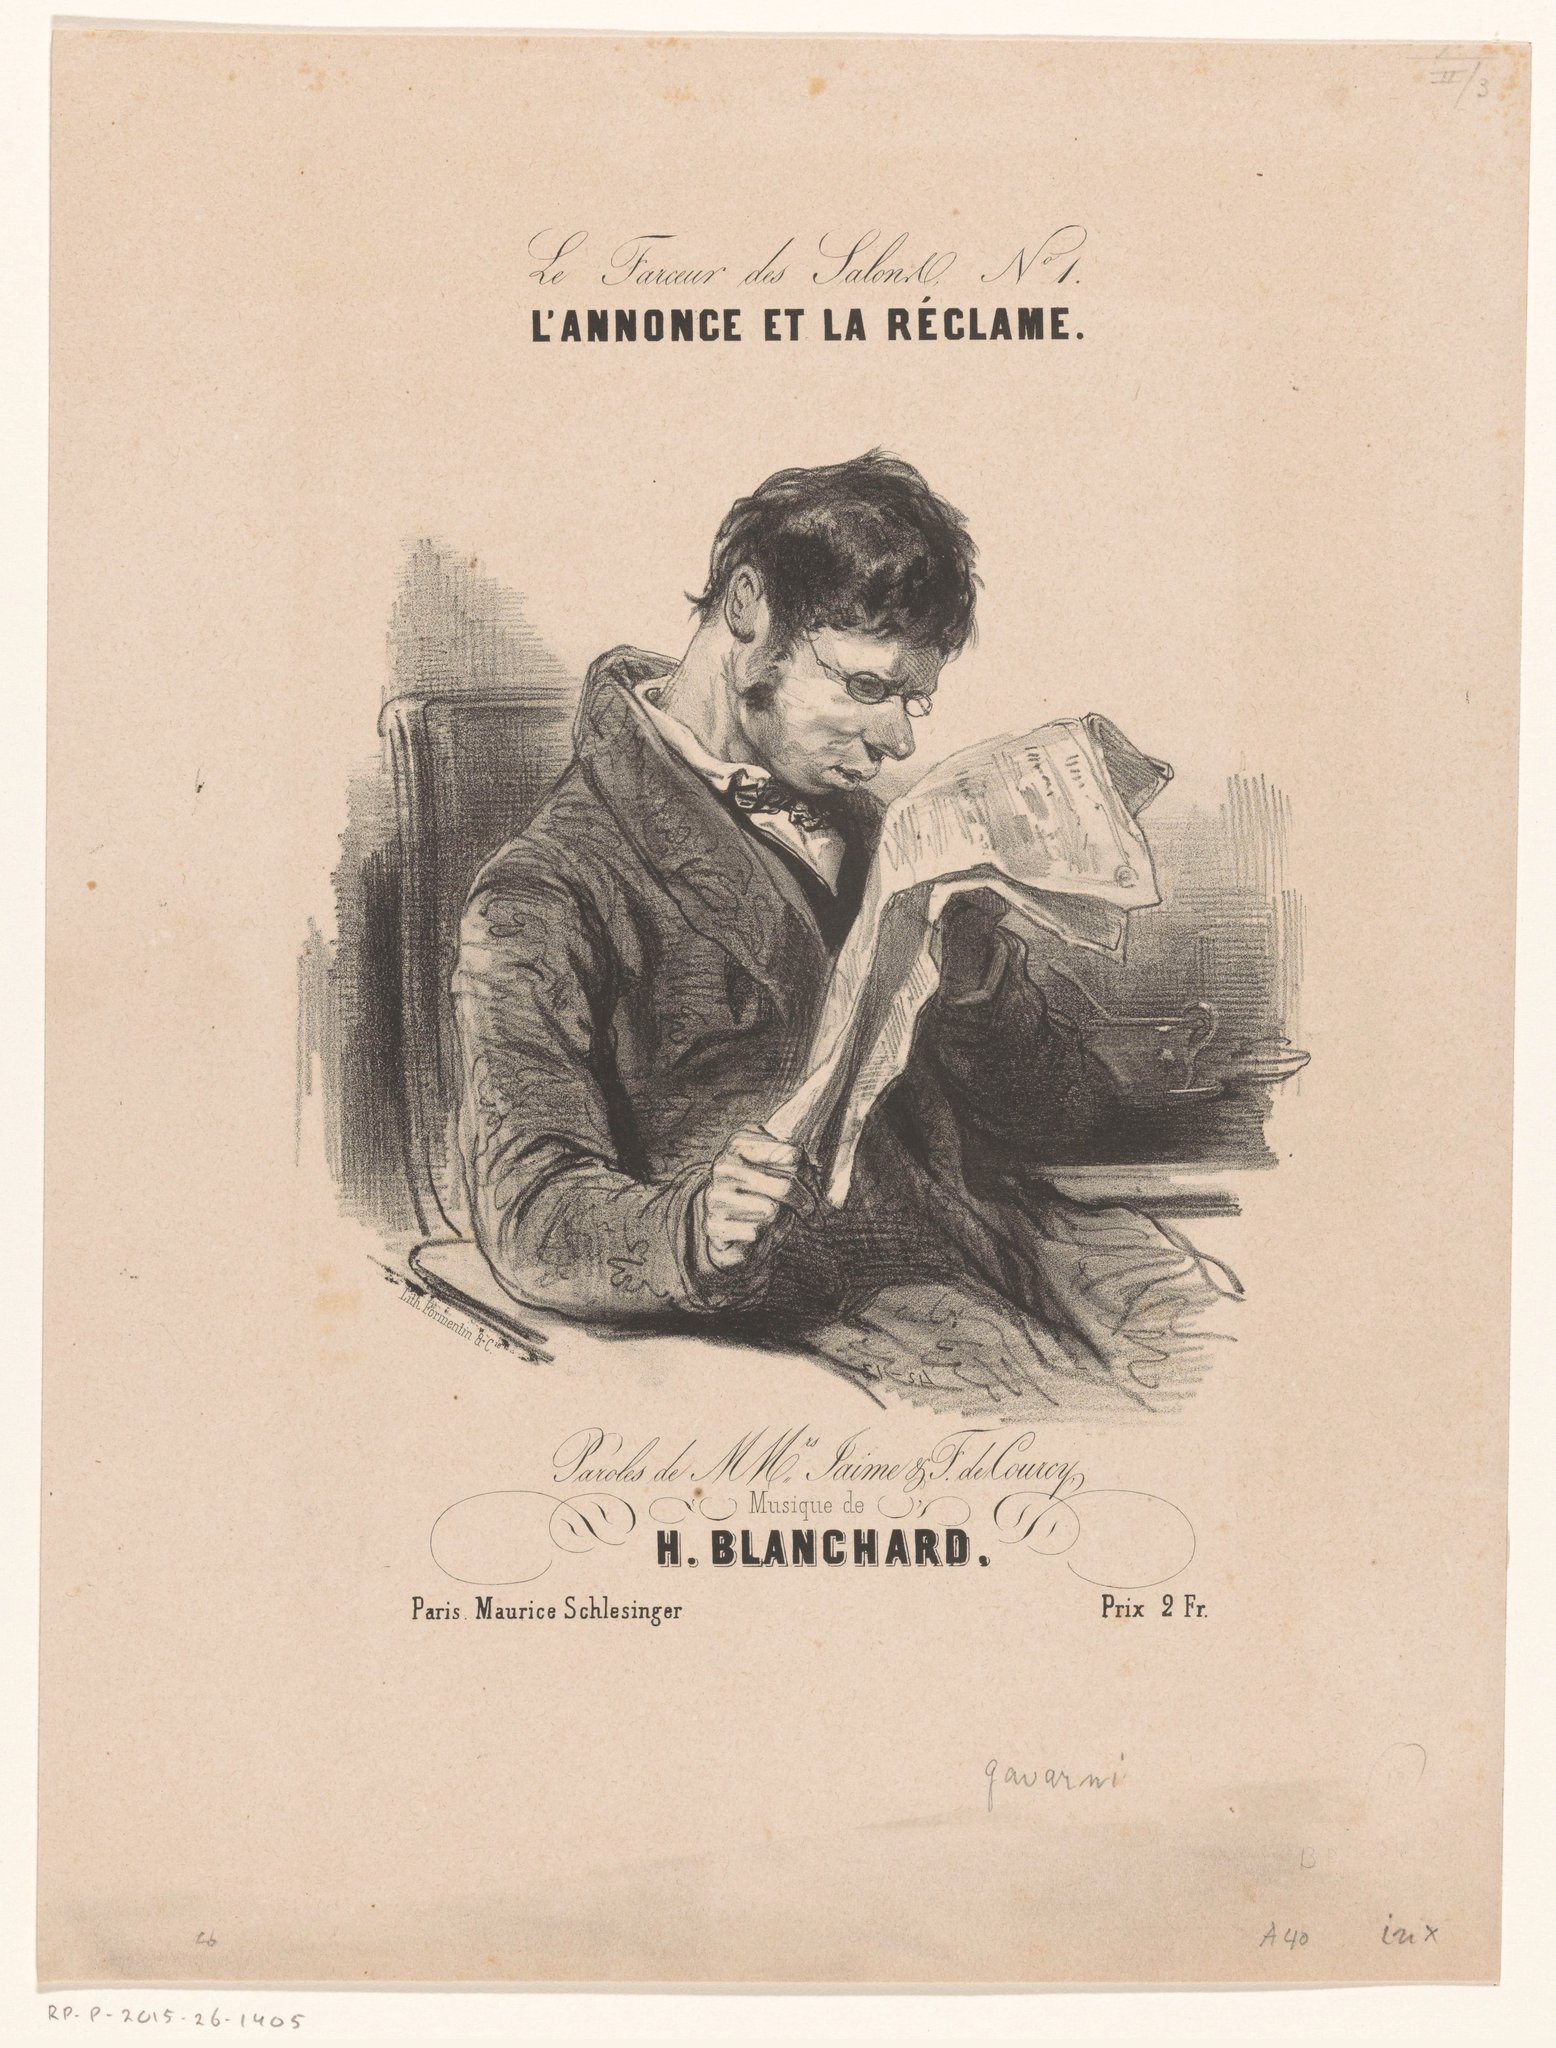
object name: print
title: Grappenmakers van de salon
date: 1821-1846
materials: paper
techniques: lithograph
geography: paris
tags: reading, newspaper, news-sheet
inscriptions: collector's mark: Lugt 2228, collector's mark: Lugt 4779